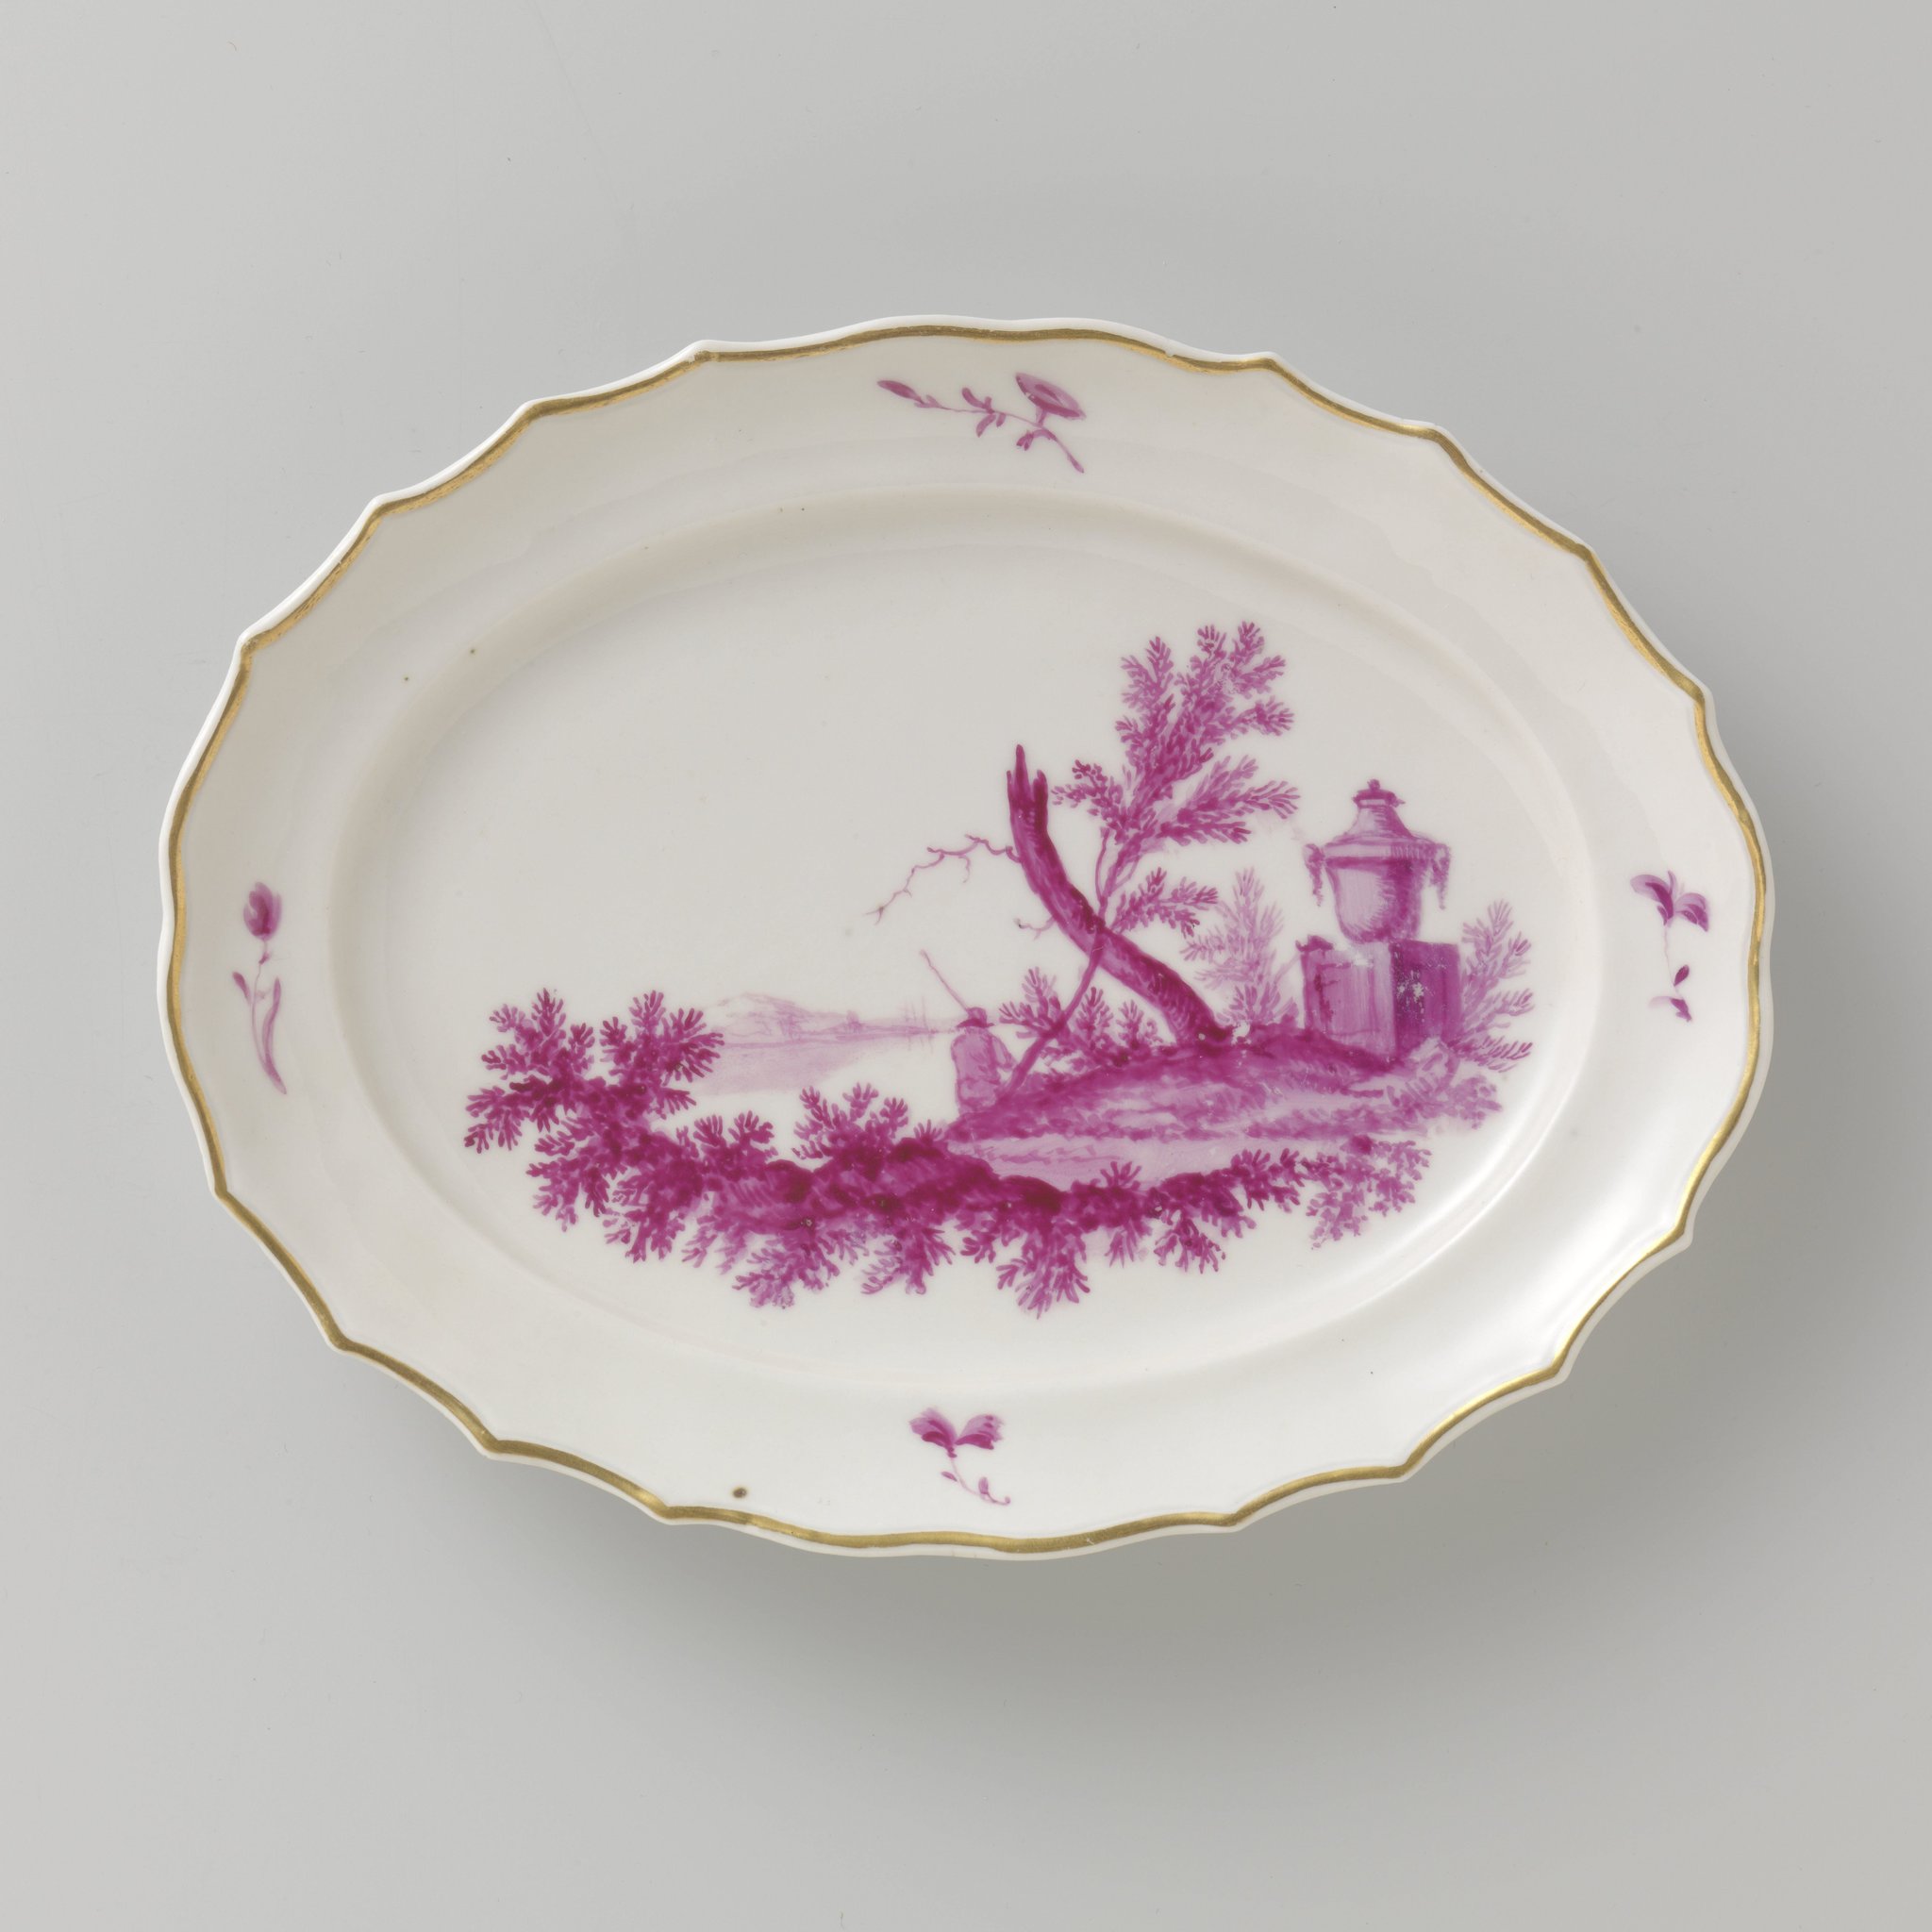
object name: platter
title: Onderschotel, veelkleurig beschilderd met een landschap met een tuinvaas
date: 1774-1778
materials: porcelain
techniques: kiln, painted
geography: loosdrecht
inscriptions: mark: ‘//’, mark: ‘/’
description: Tureen and stand. Porcelain. Loosdrecht c. 1774 - 1778. Factory of Joannes de Mol.